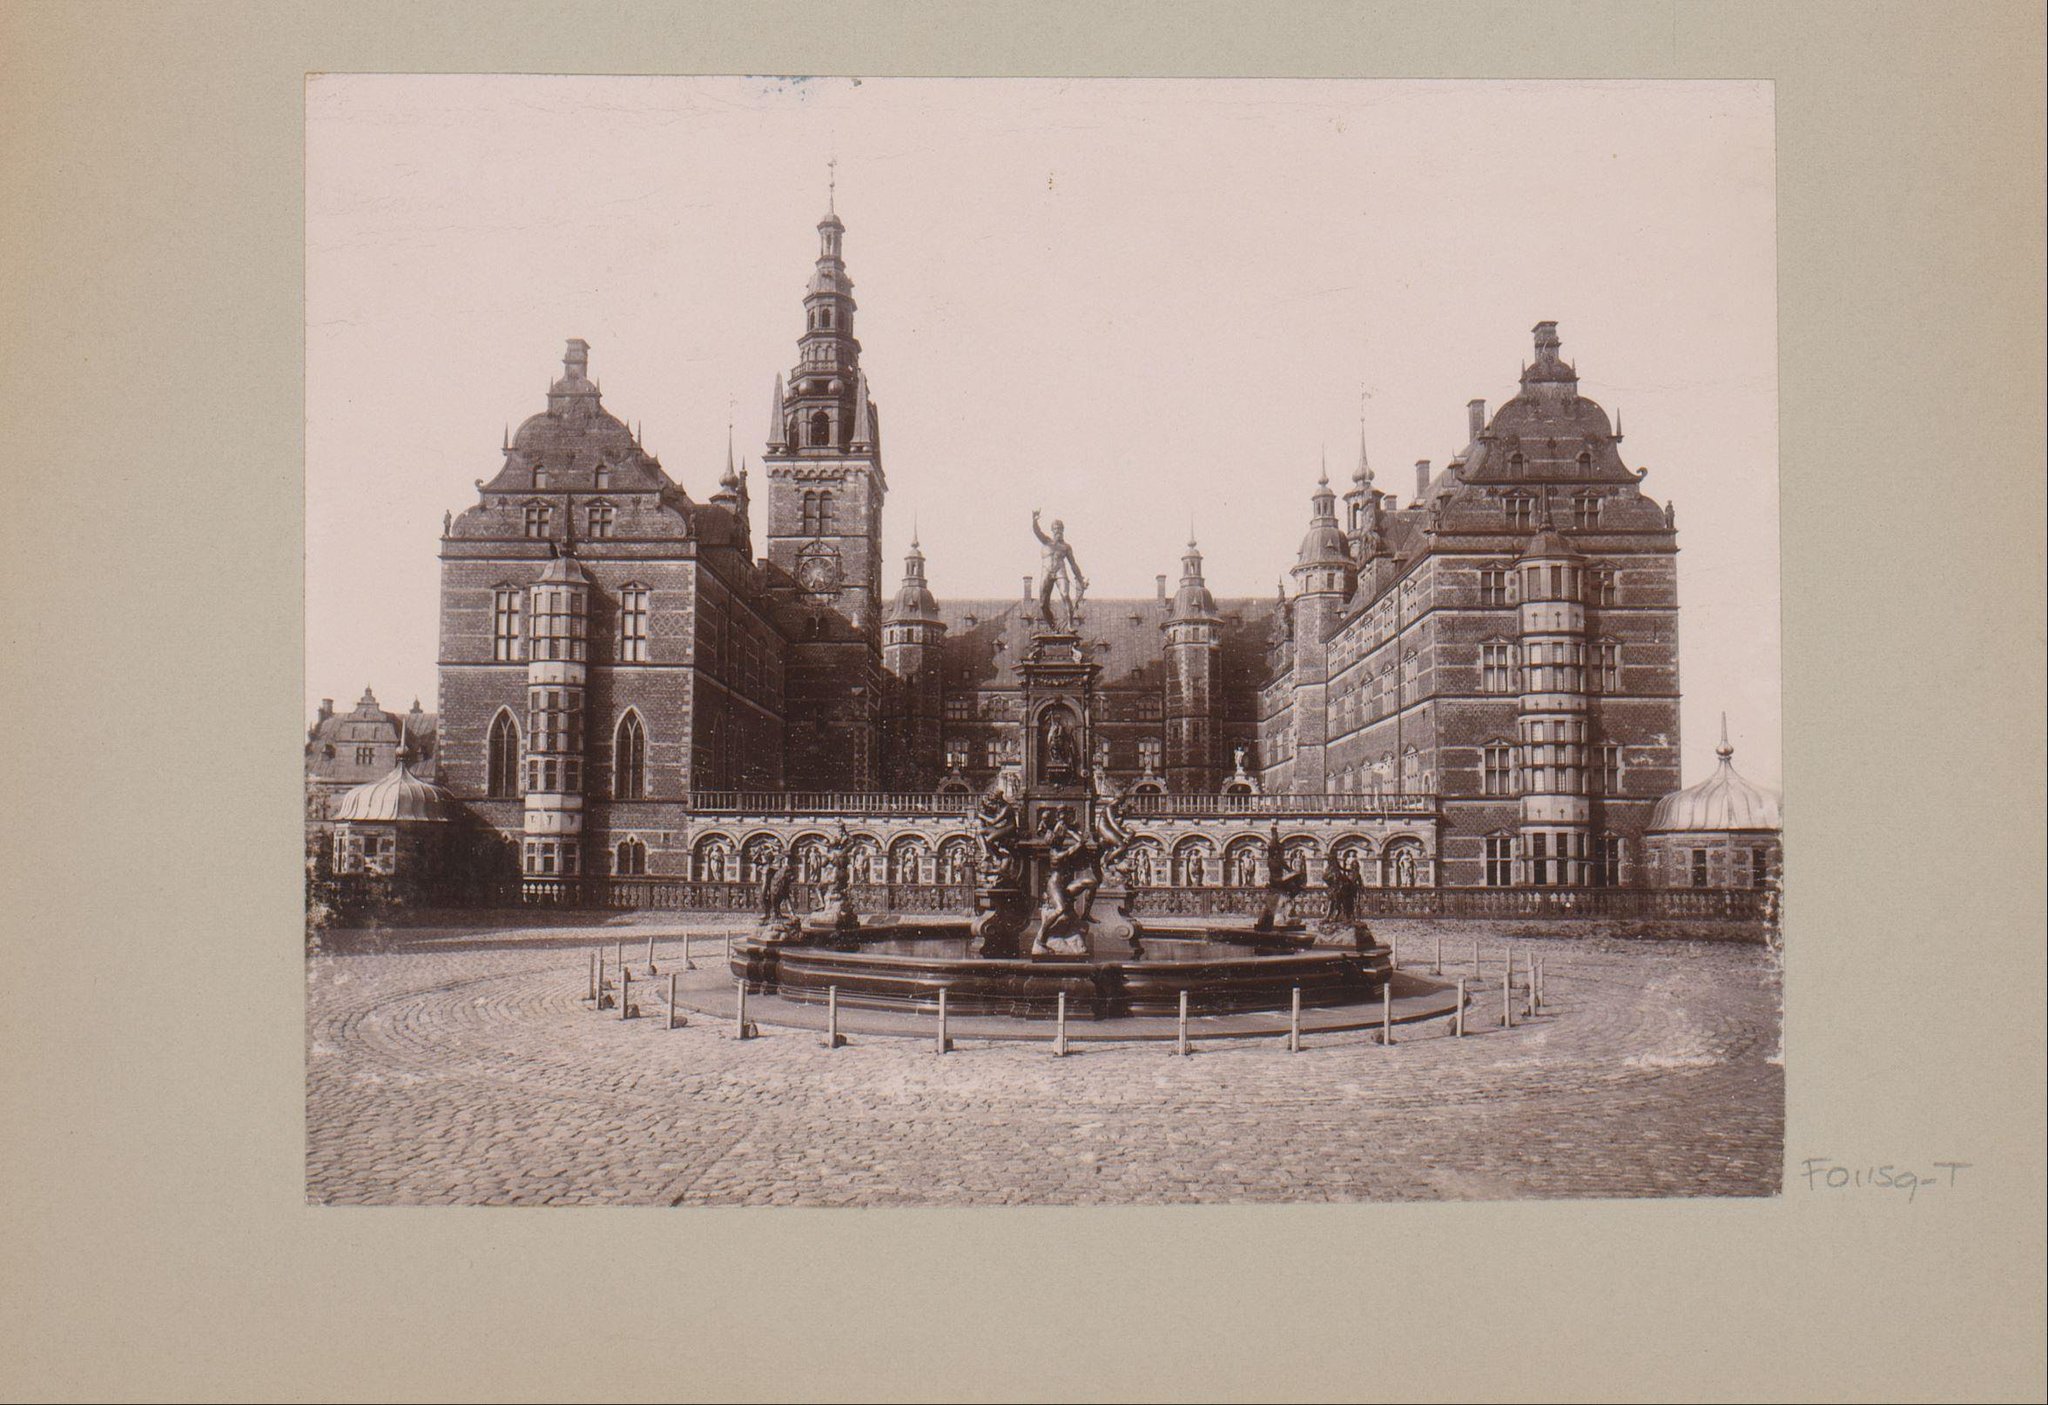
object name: photograph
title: Gezicht op Slot Frederiksborg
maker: Anonymous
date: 1880-1900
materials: photographic support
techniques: collodion silver print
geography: hillerød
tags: castle, monument, statue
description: Onderdeel van Reisalbum met opnames van bezienswaardigheden in Zweden, Noorwegen, Denemarken, Beieren, Milaan en Parijs.